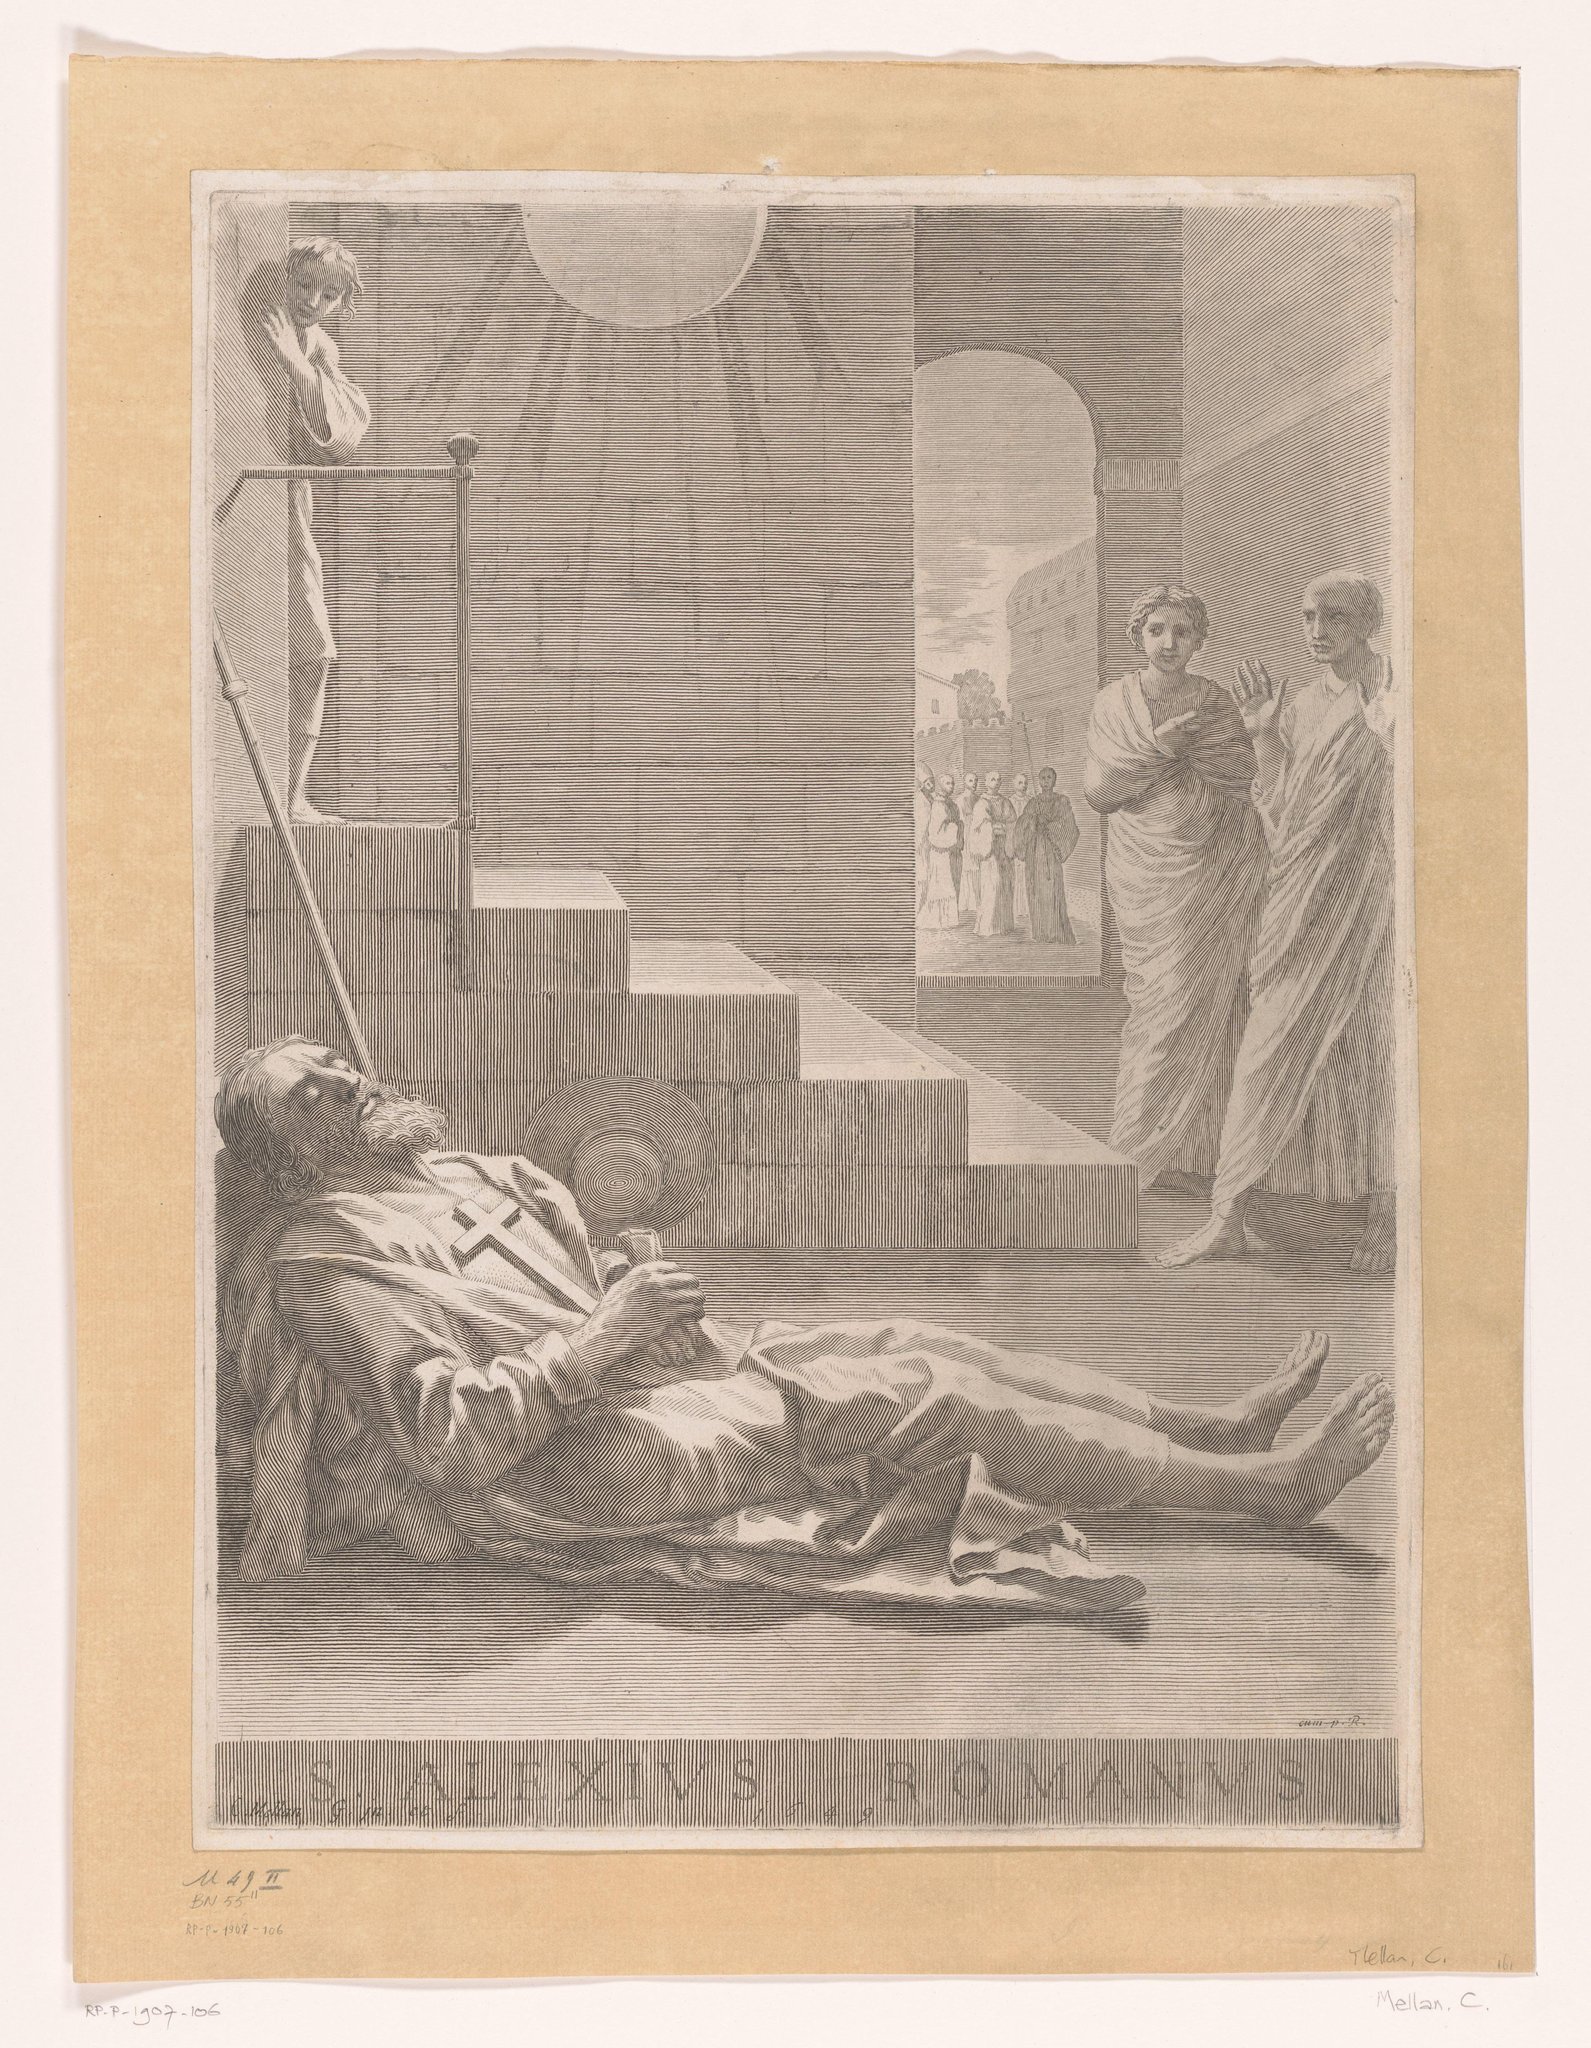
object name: print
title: Alexius van Edessa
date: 1649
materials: paper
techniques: engraving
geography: france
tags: the confessor alexi(u)s of rome (or edessa); possible attributes: staircase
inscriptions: watermark